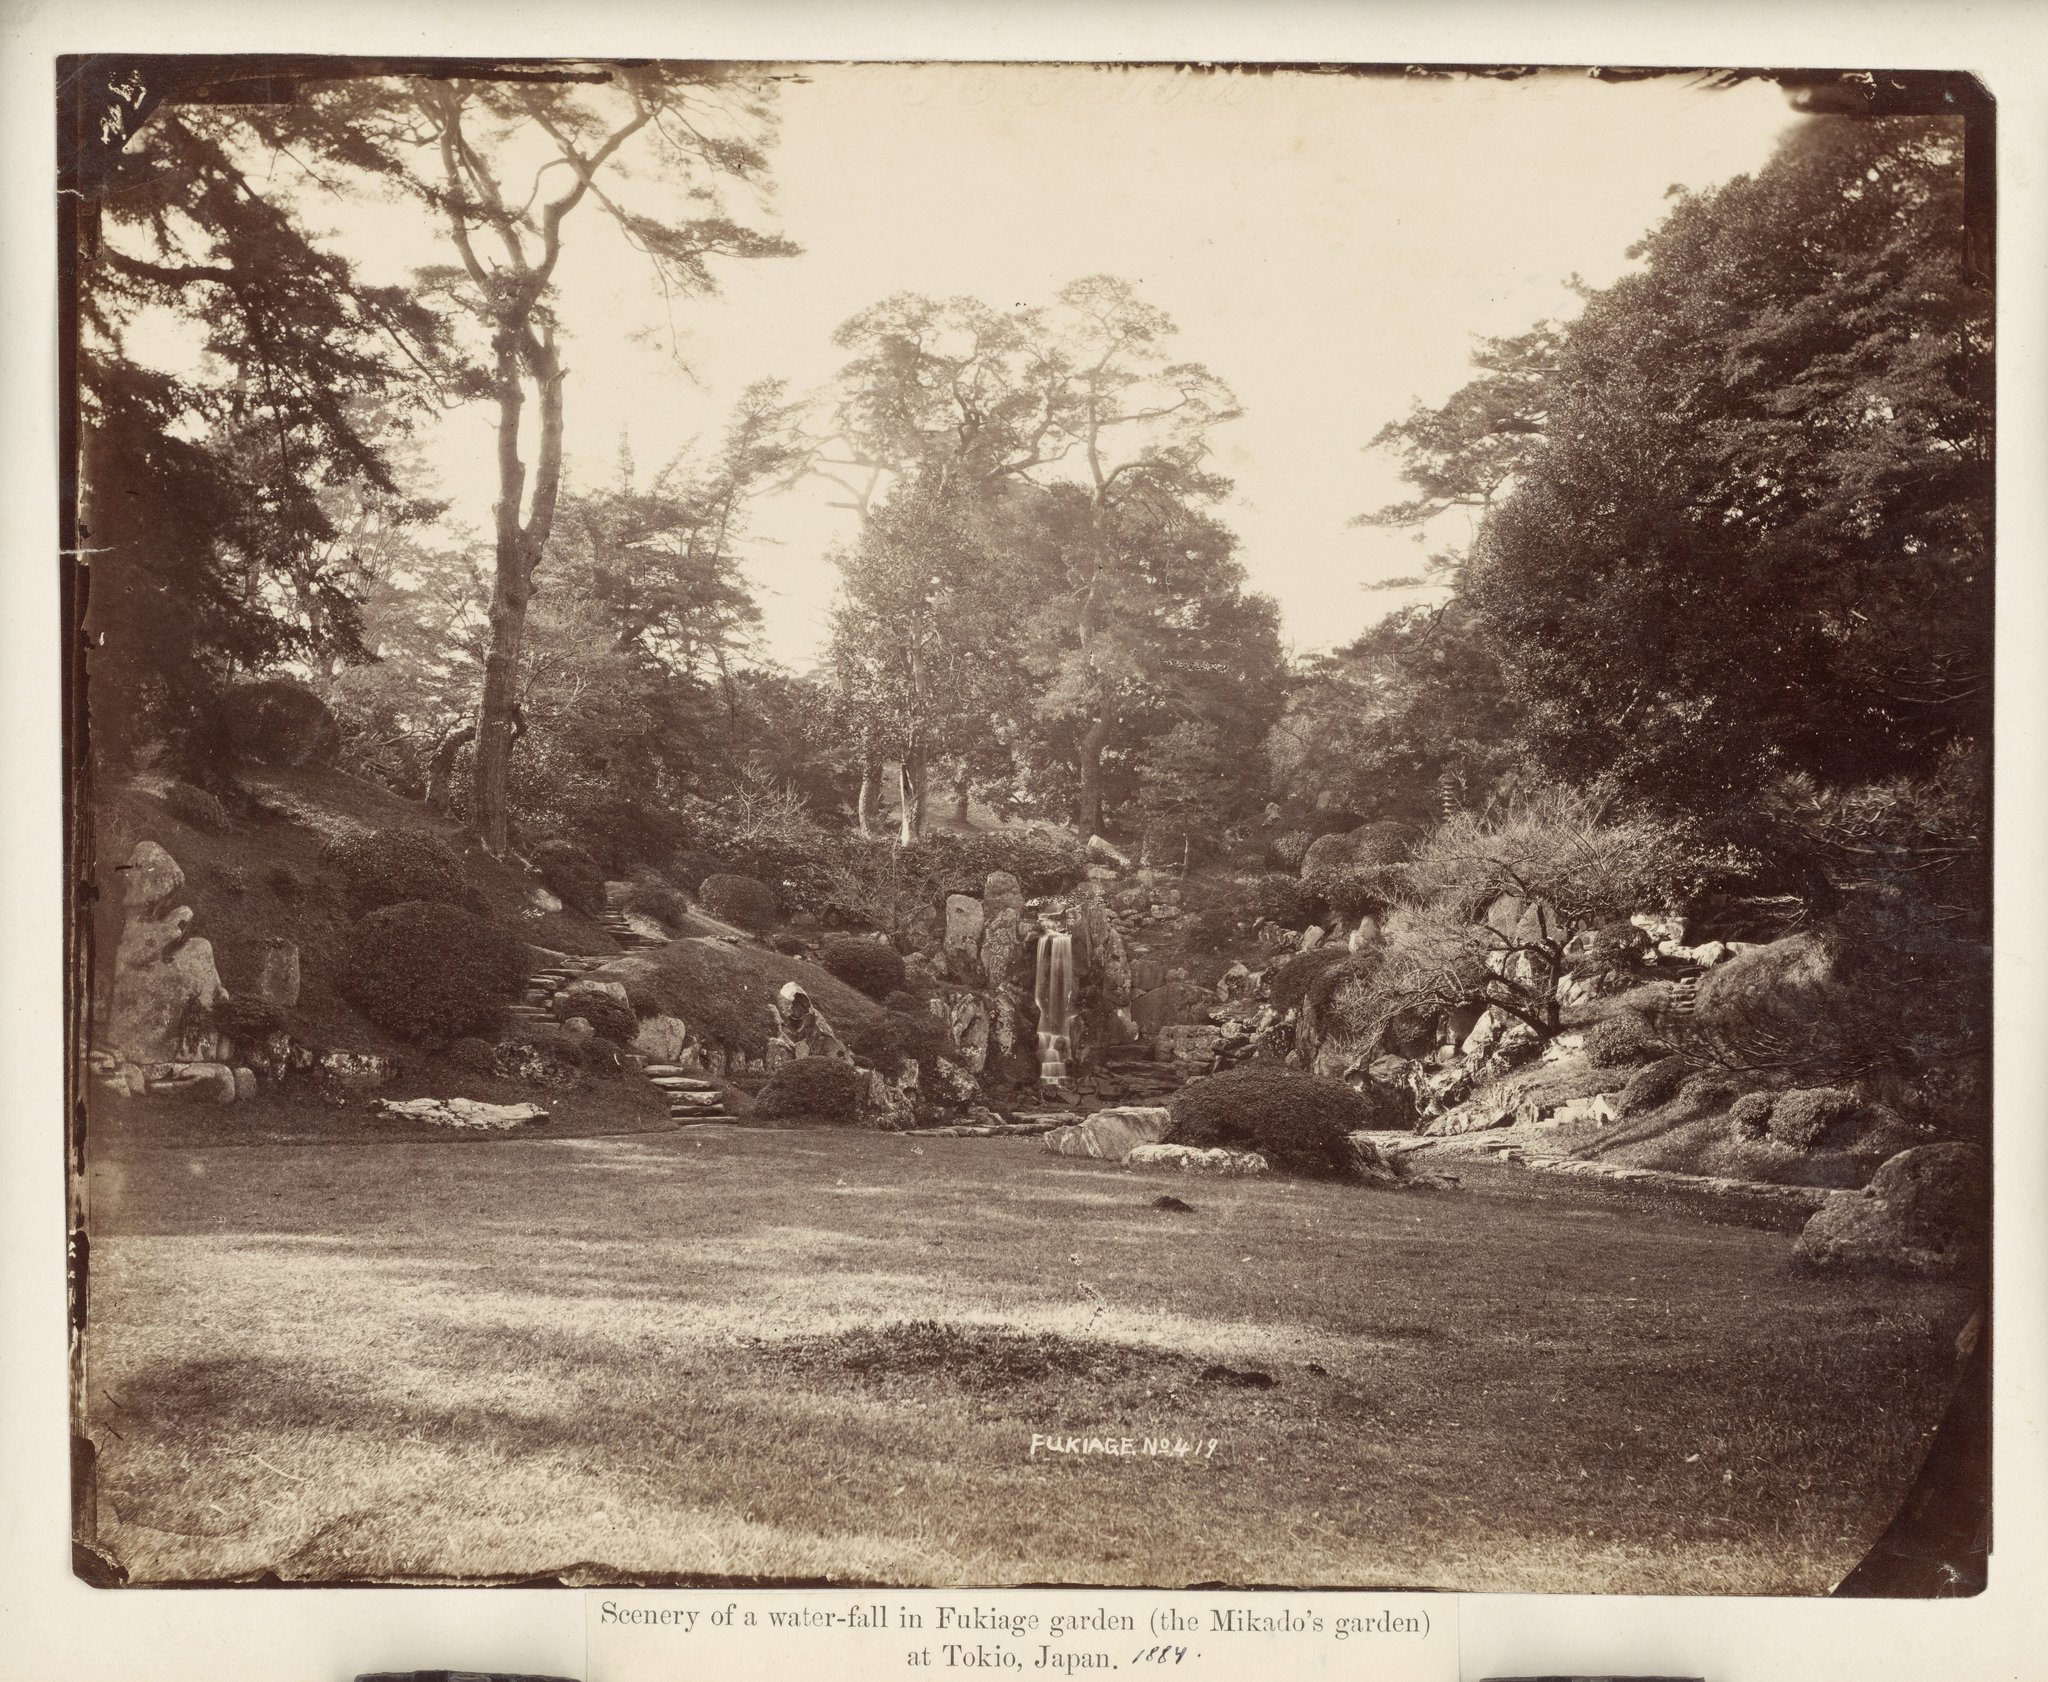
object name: photograph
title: Scenery of a water-fall in Fukiage garden (the Mikado' s garden) at Tokio, Japan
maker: Anonymous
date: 1884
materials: cardboard, paper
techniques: albumen print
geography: tokyo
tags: rock-garden, waterfall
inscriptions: inscription: ‘FUKIAGE. No 419’